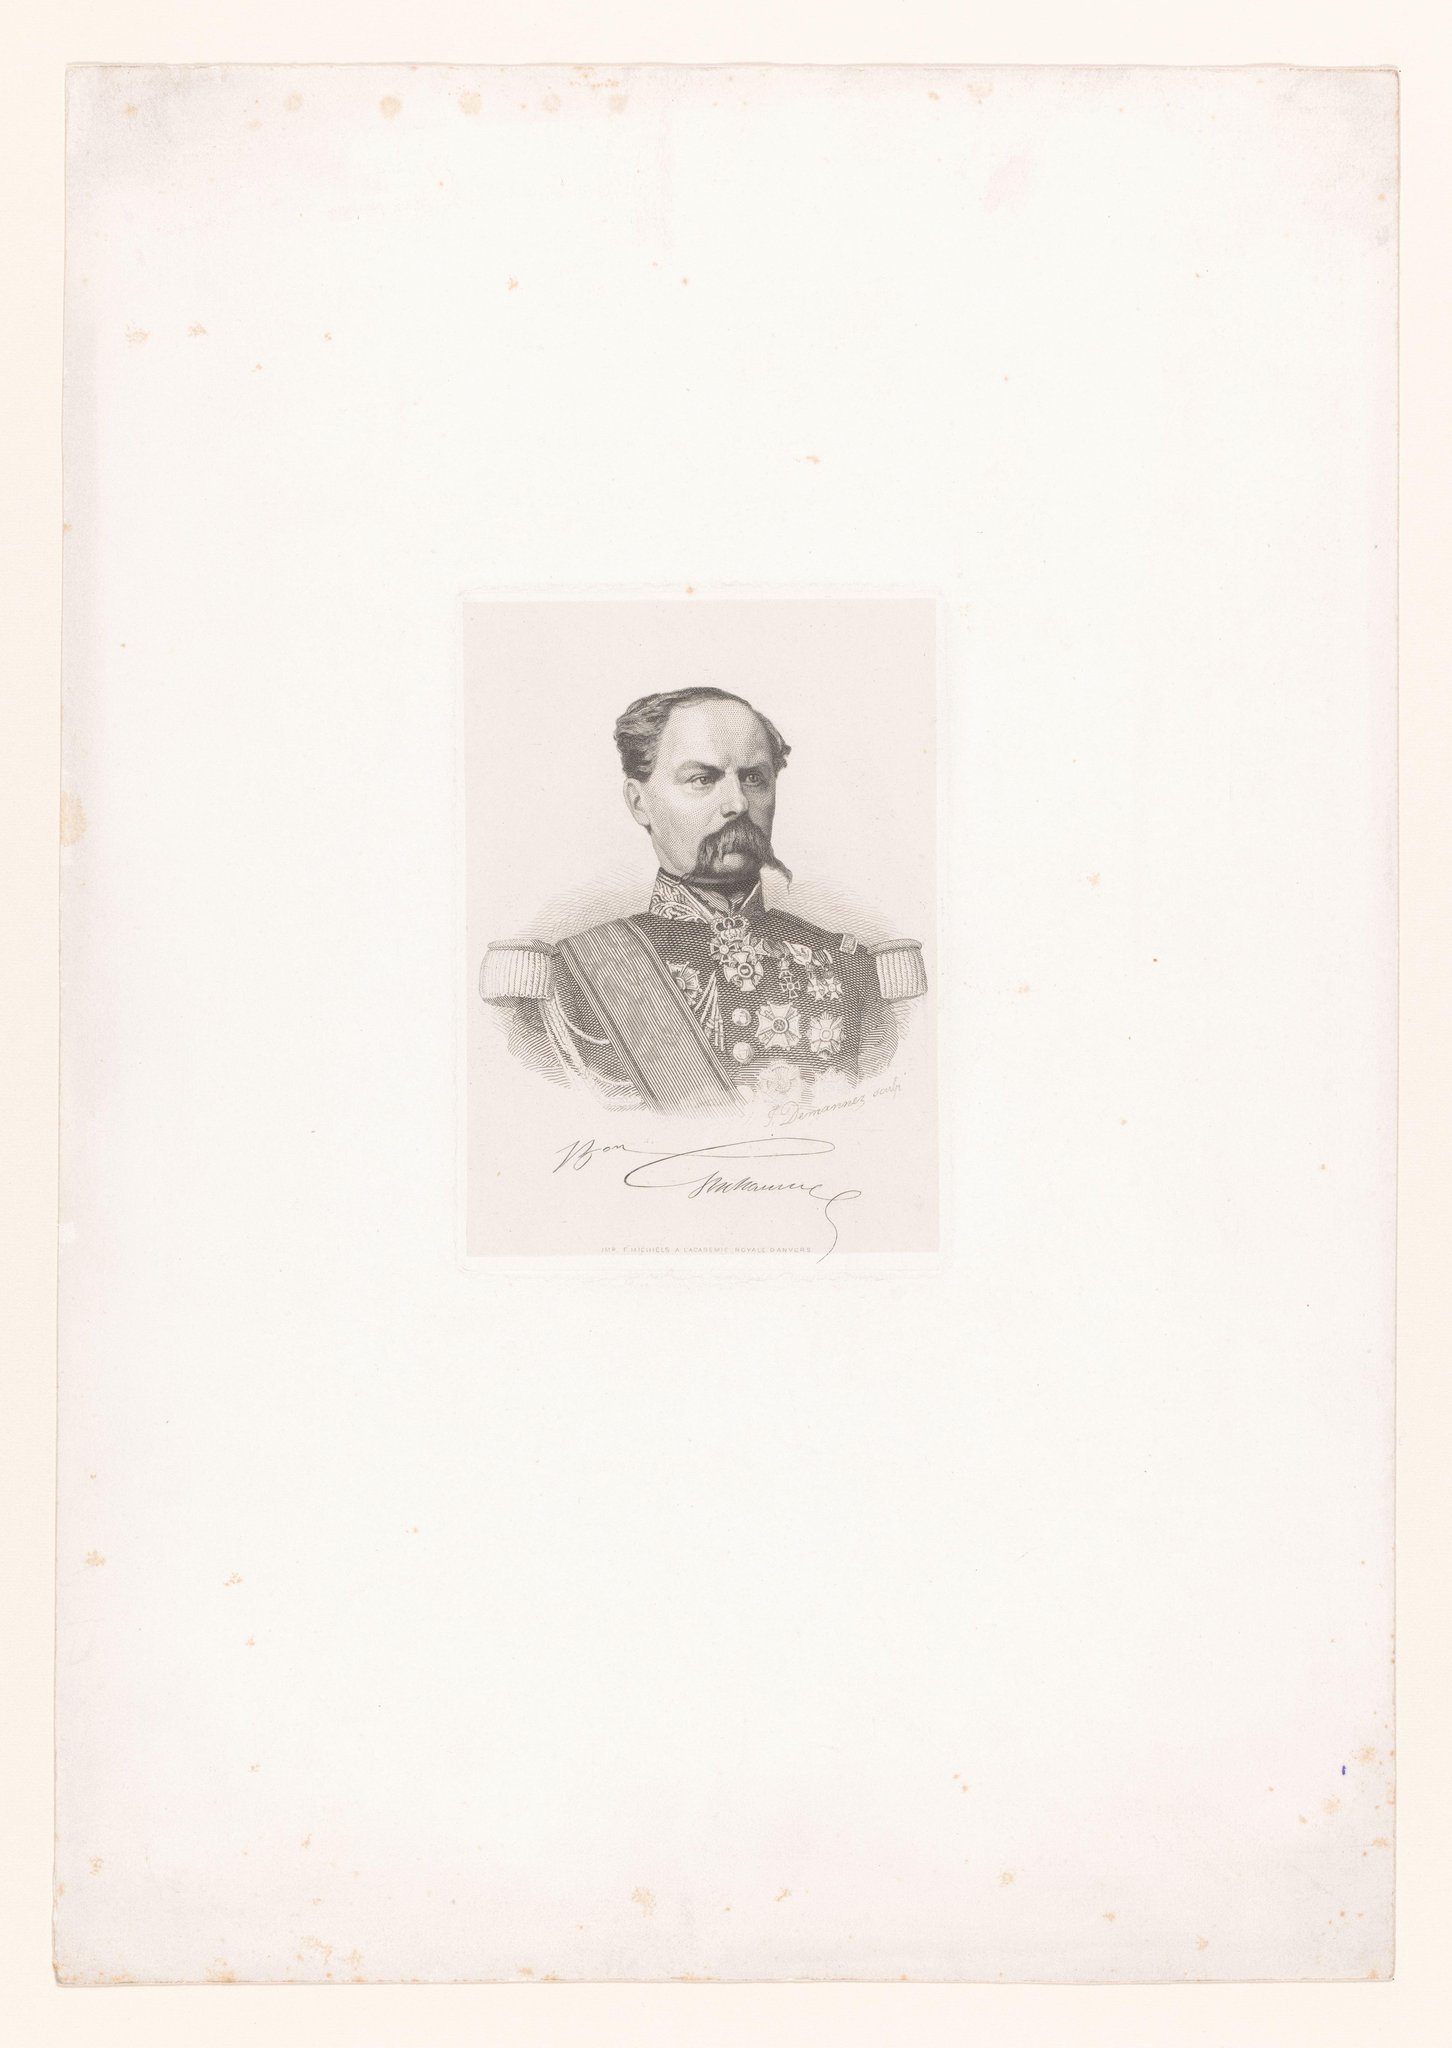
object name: print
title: Portret van een onbekende generaal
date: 1836-1902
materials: paper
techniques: engraving, etching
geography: antwerp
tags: commander-in-chief, general, marshal, adult man, historical persons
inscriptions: collector's mark: Lugt 2228